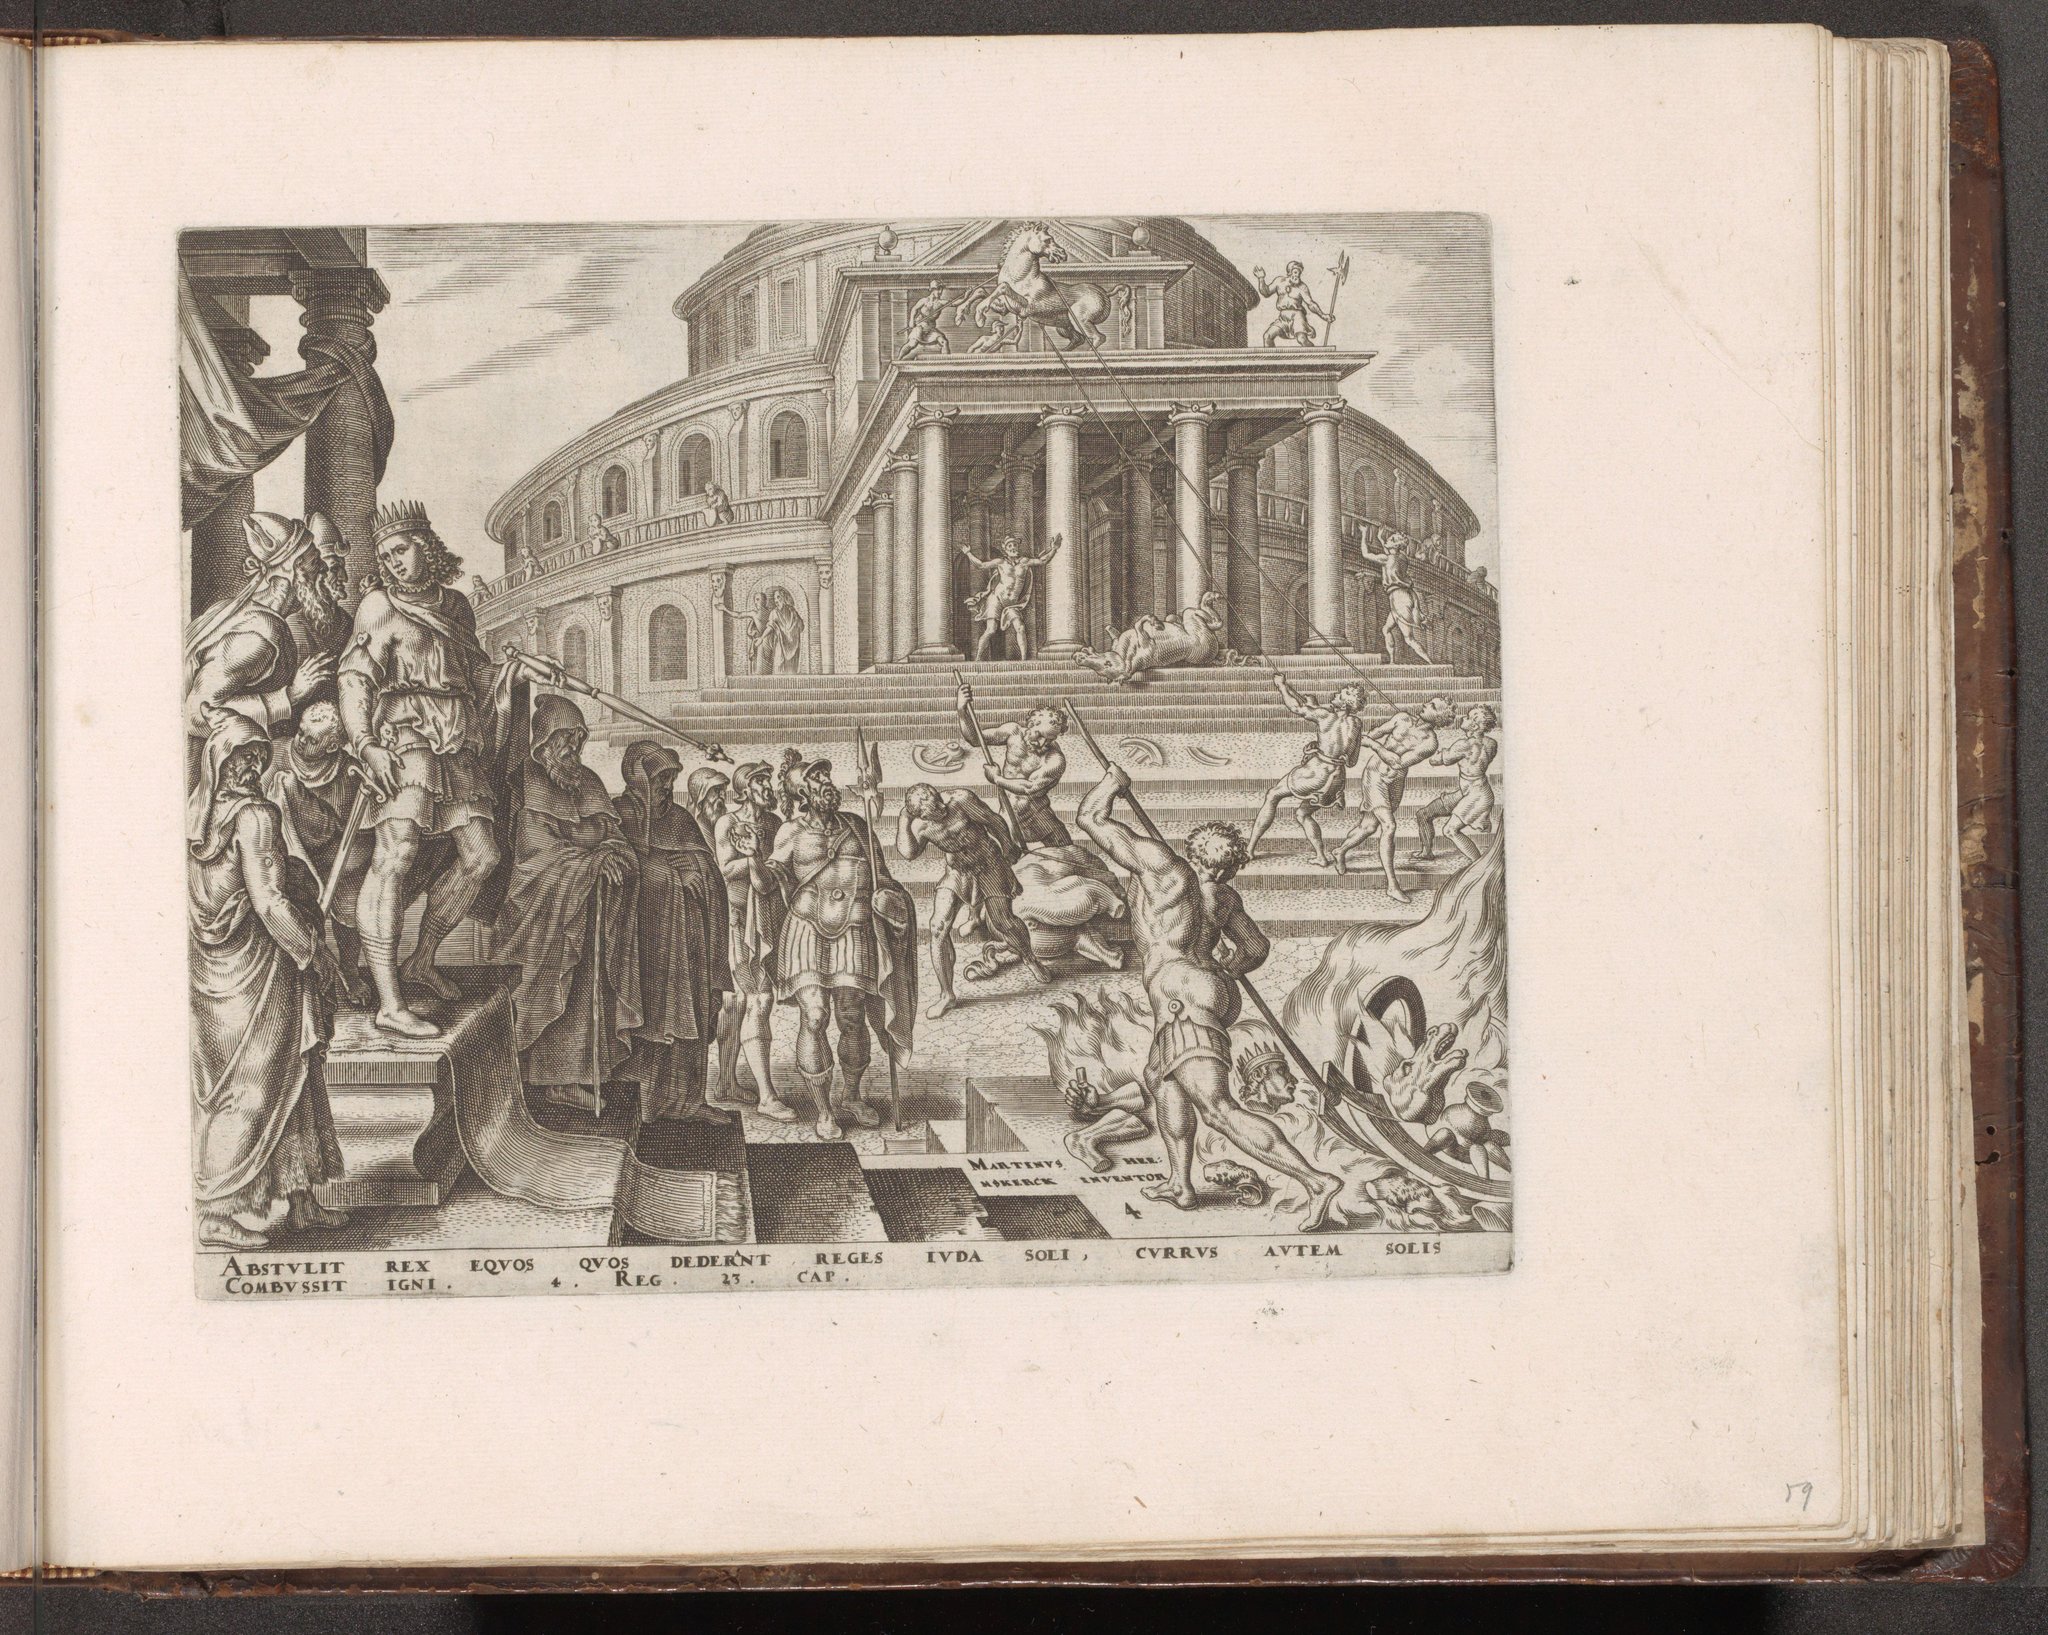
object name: print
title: Thesaurus sacrarum historiaru[m] veteris testame[n]ti, elega[n]tissimis imaginibus expressu[m] excelle[n]tissimoru[m] in hac arte viroru[m] opera: nu[n]c primu[m] in luce[m] editus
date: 1567-1571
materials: paper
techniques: engraving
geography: amsterdam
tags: josiah removes the horses and burns the chariots used in the worship of the sun-god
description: Koning Josia staat op een trap op het plein voor de tempel en bekijkt hoe standbeelden van paarden en zonnewagens van de tempelingang worden getrokken en op het plein worden verbrand. De standbeelden waren opgericht ter ere van de zon. Onder de voorstelling een verwijzing in het Latijn naar de Bijbeltekst in 2 Kon. 23. Prent maakt deel uit van een album.